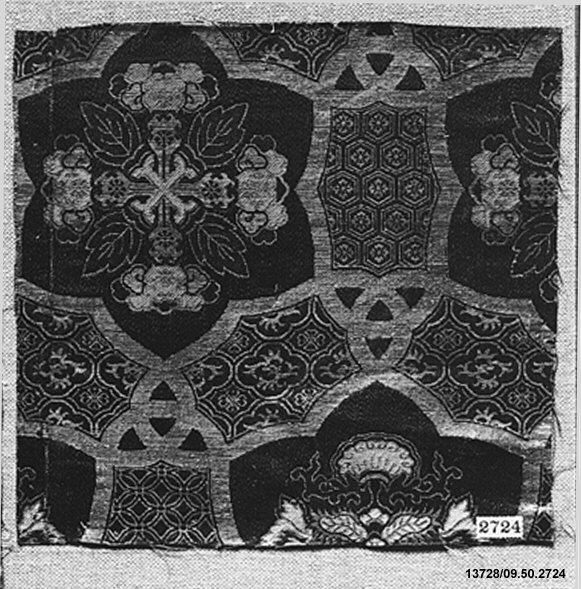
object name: piece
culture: japanese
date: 1615-1868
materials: silk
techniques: brocade